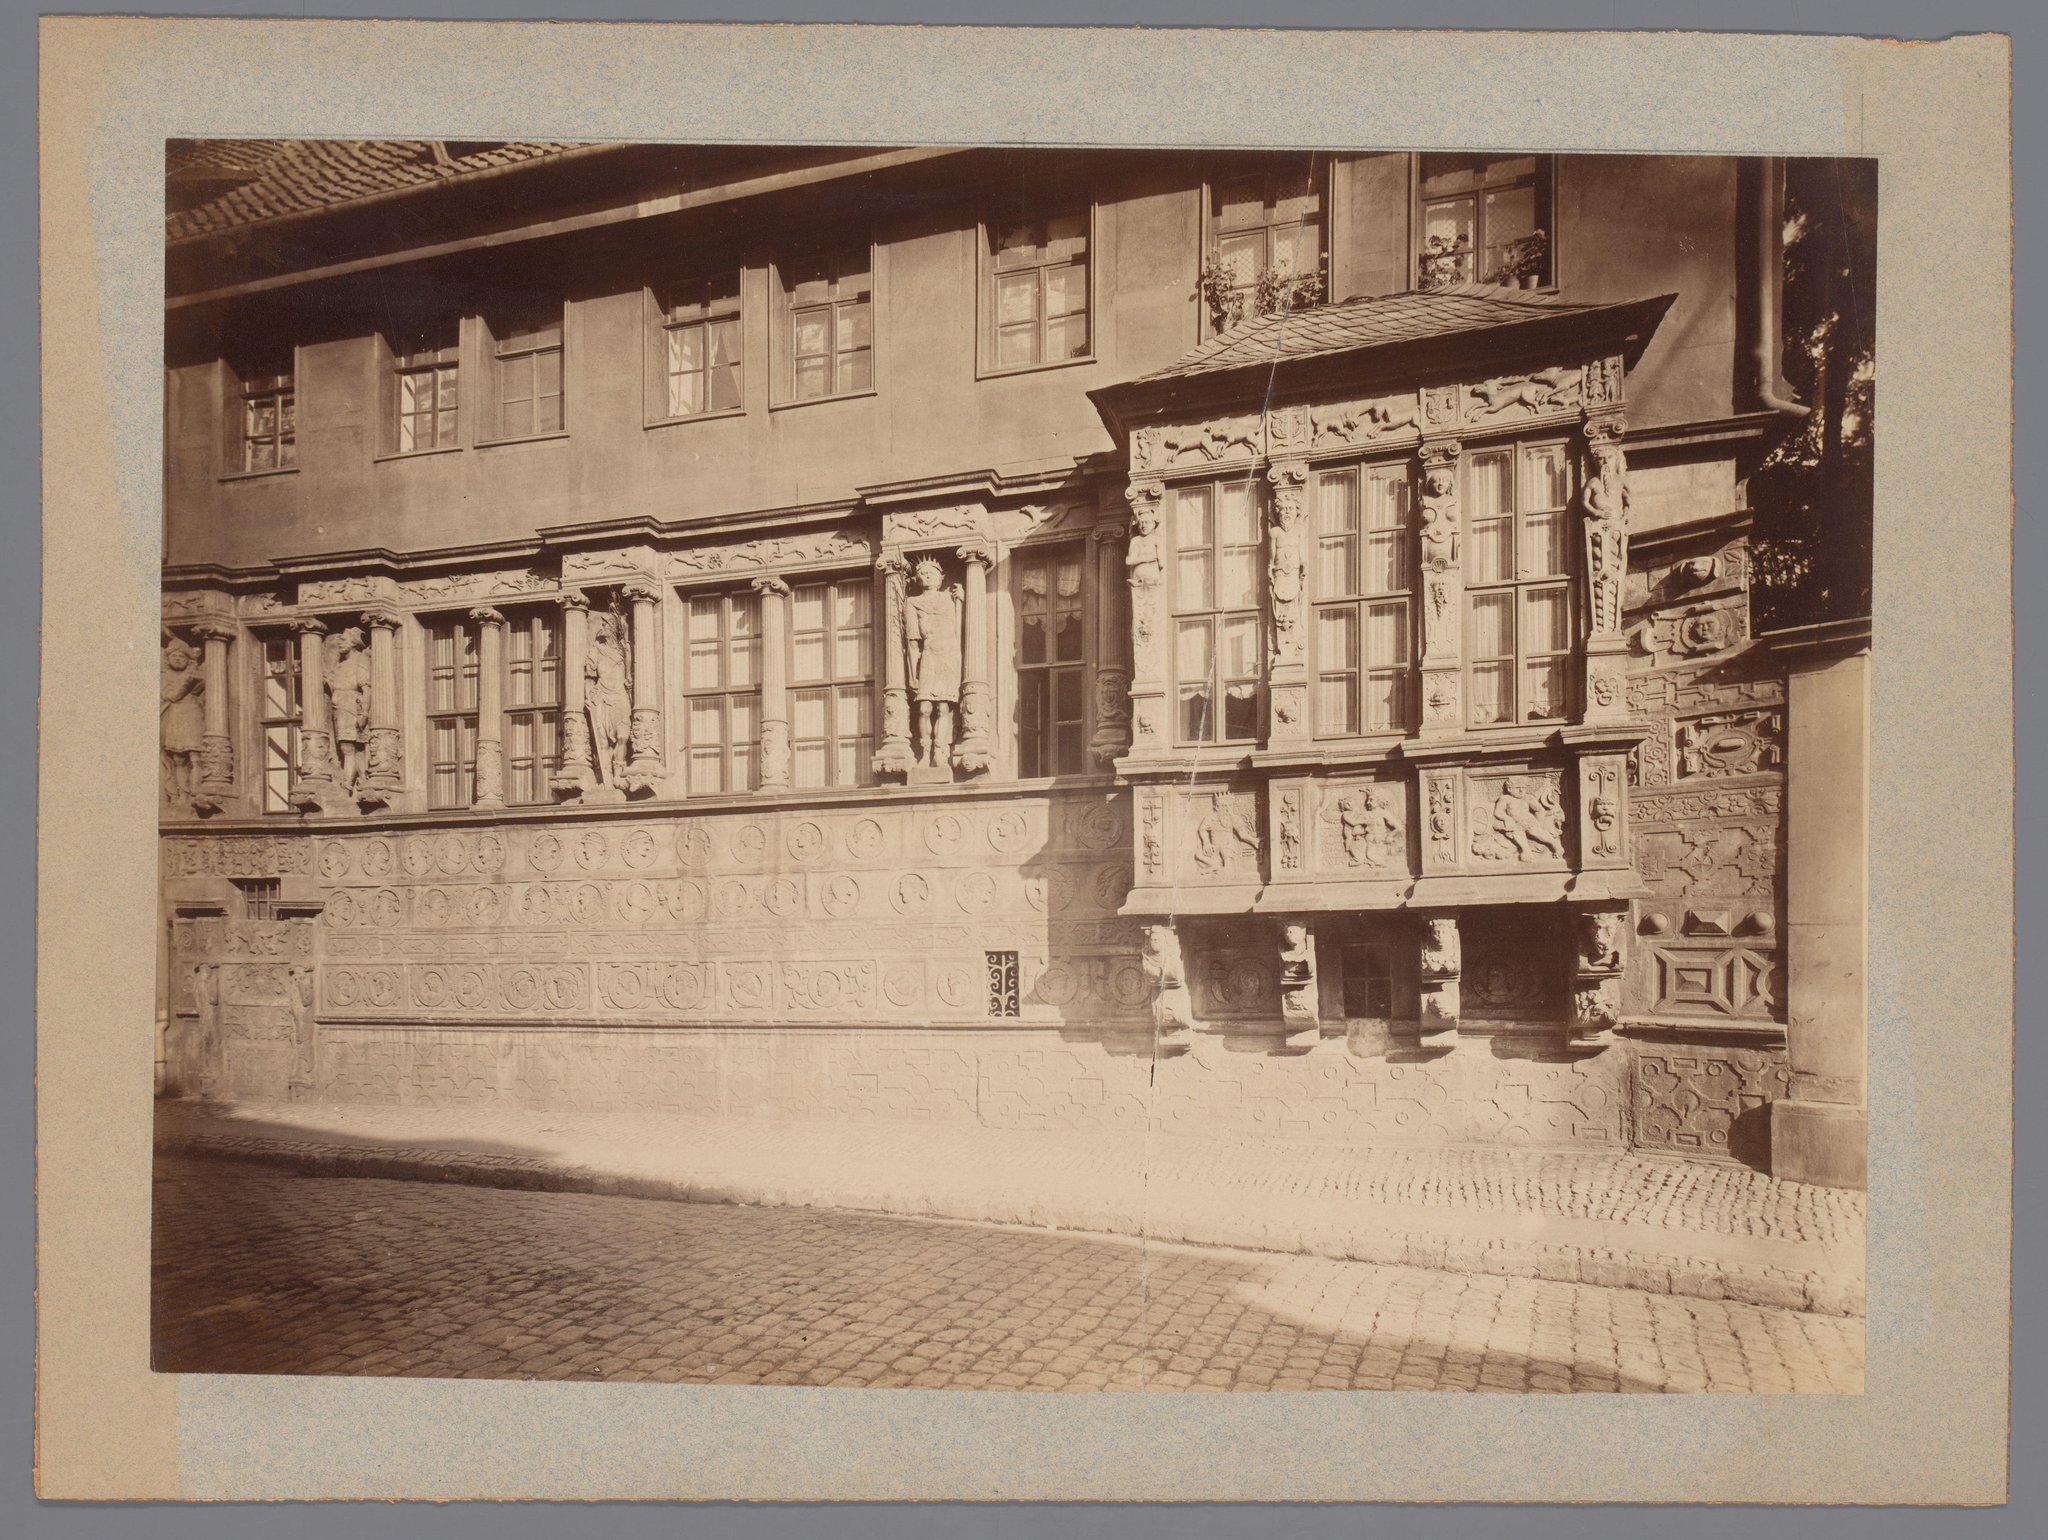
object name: photograph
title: Gezicht op reliëfs rondom de raampartijen van een gebouw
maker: Anonymous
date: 1850-1900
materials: cardboard, photographic support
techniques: albumen print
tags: window